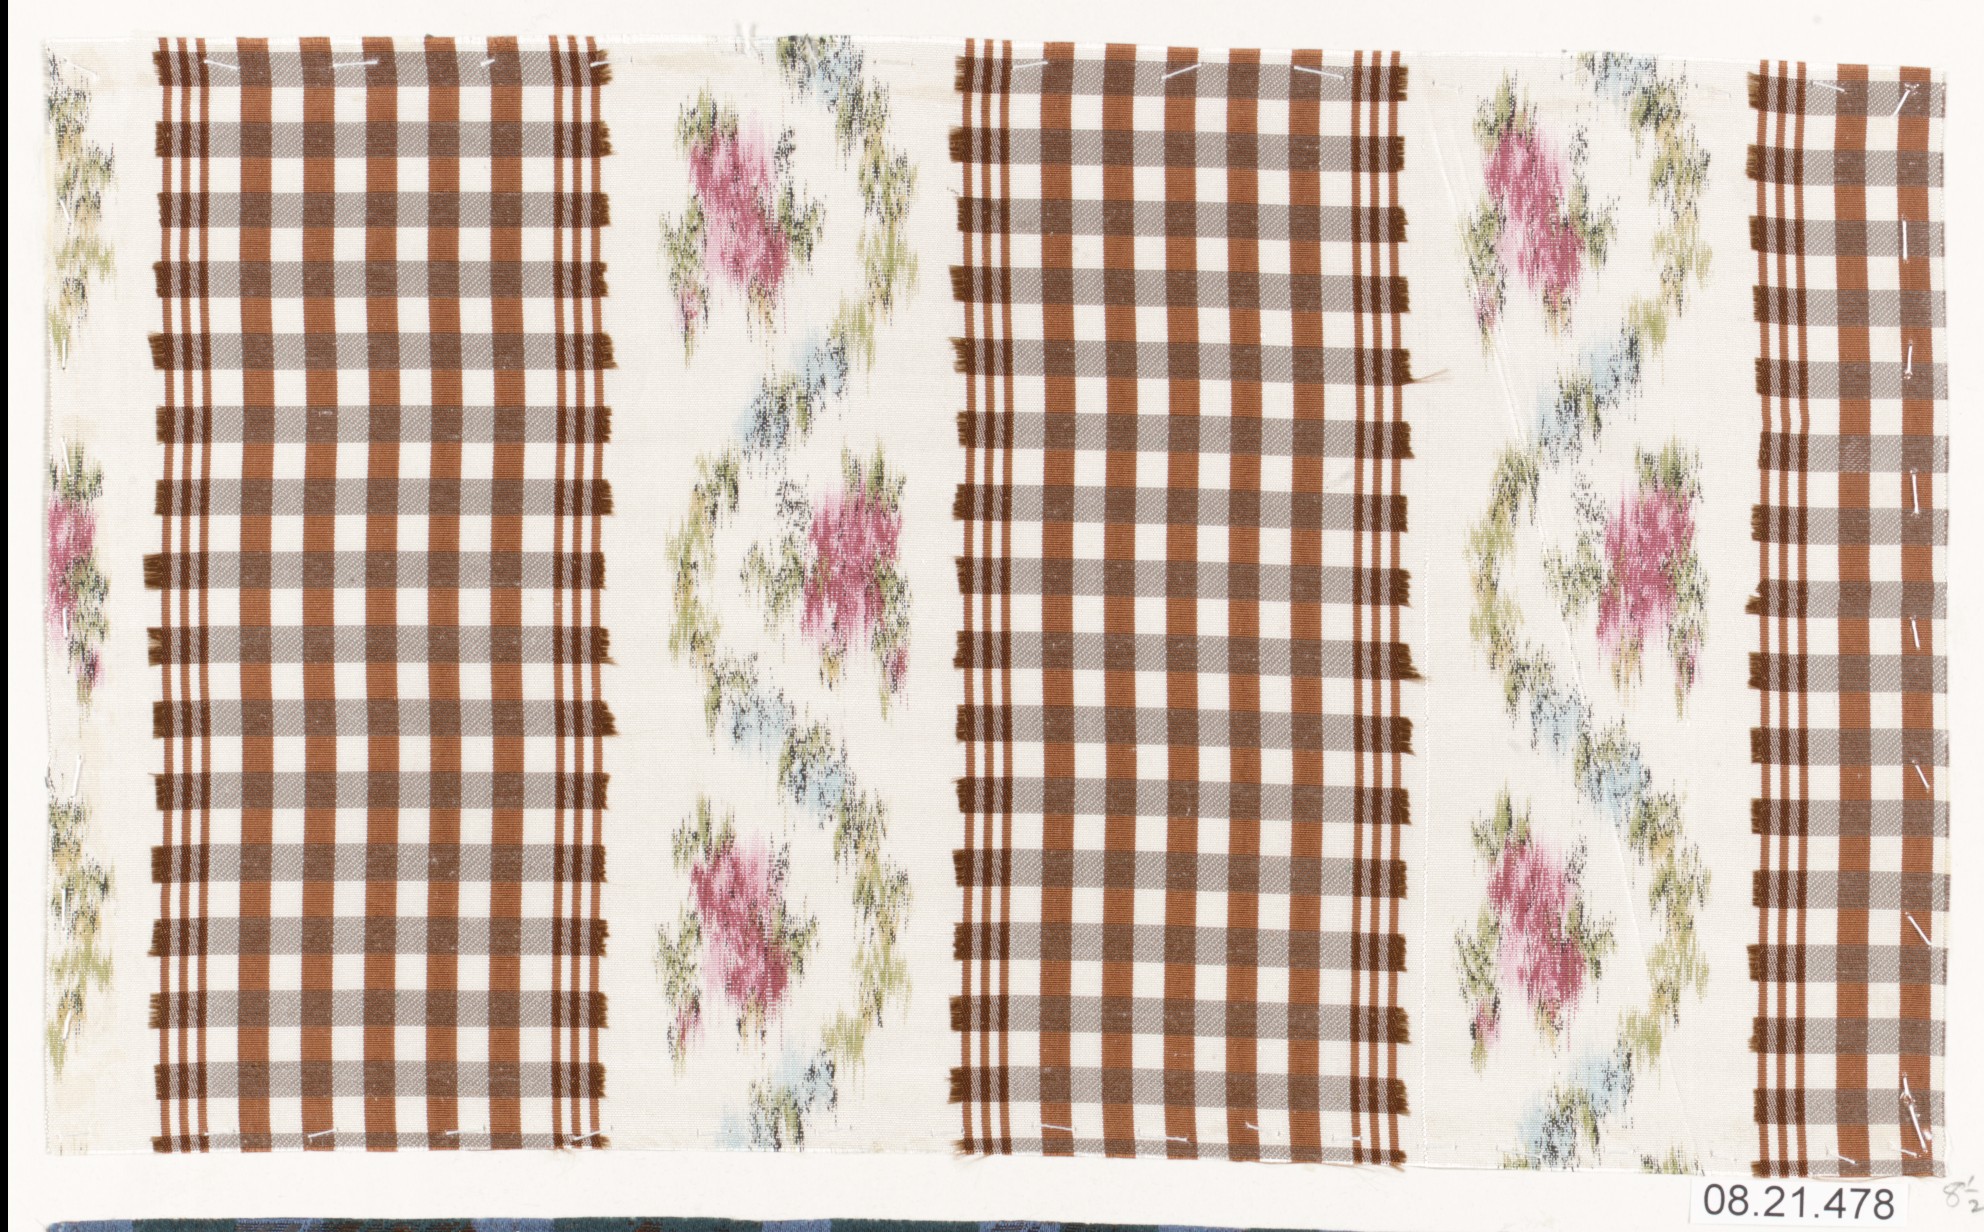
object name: textile sample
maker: Anonymous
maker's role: designer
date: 1900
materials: silk